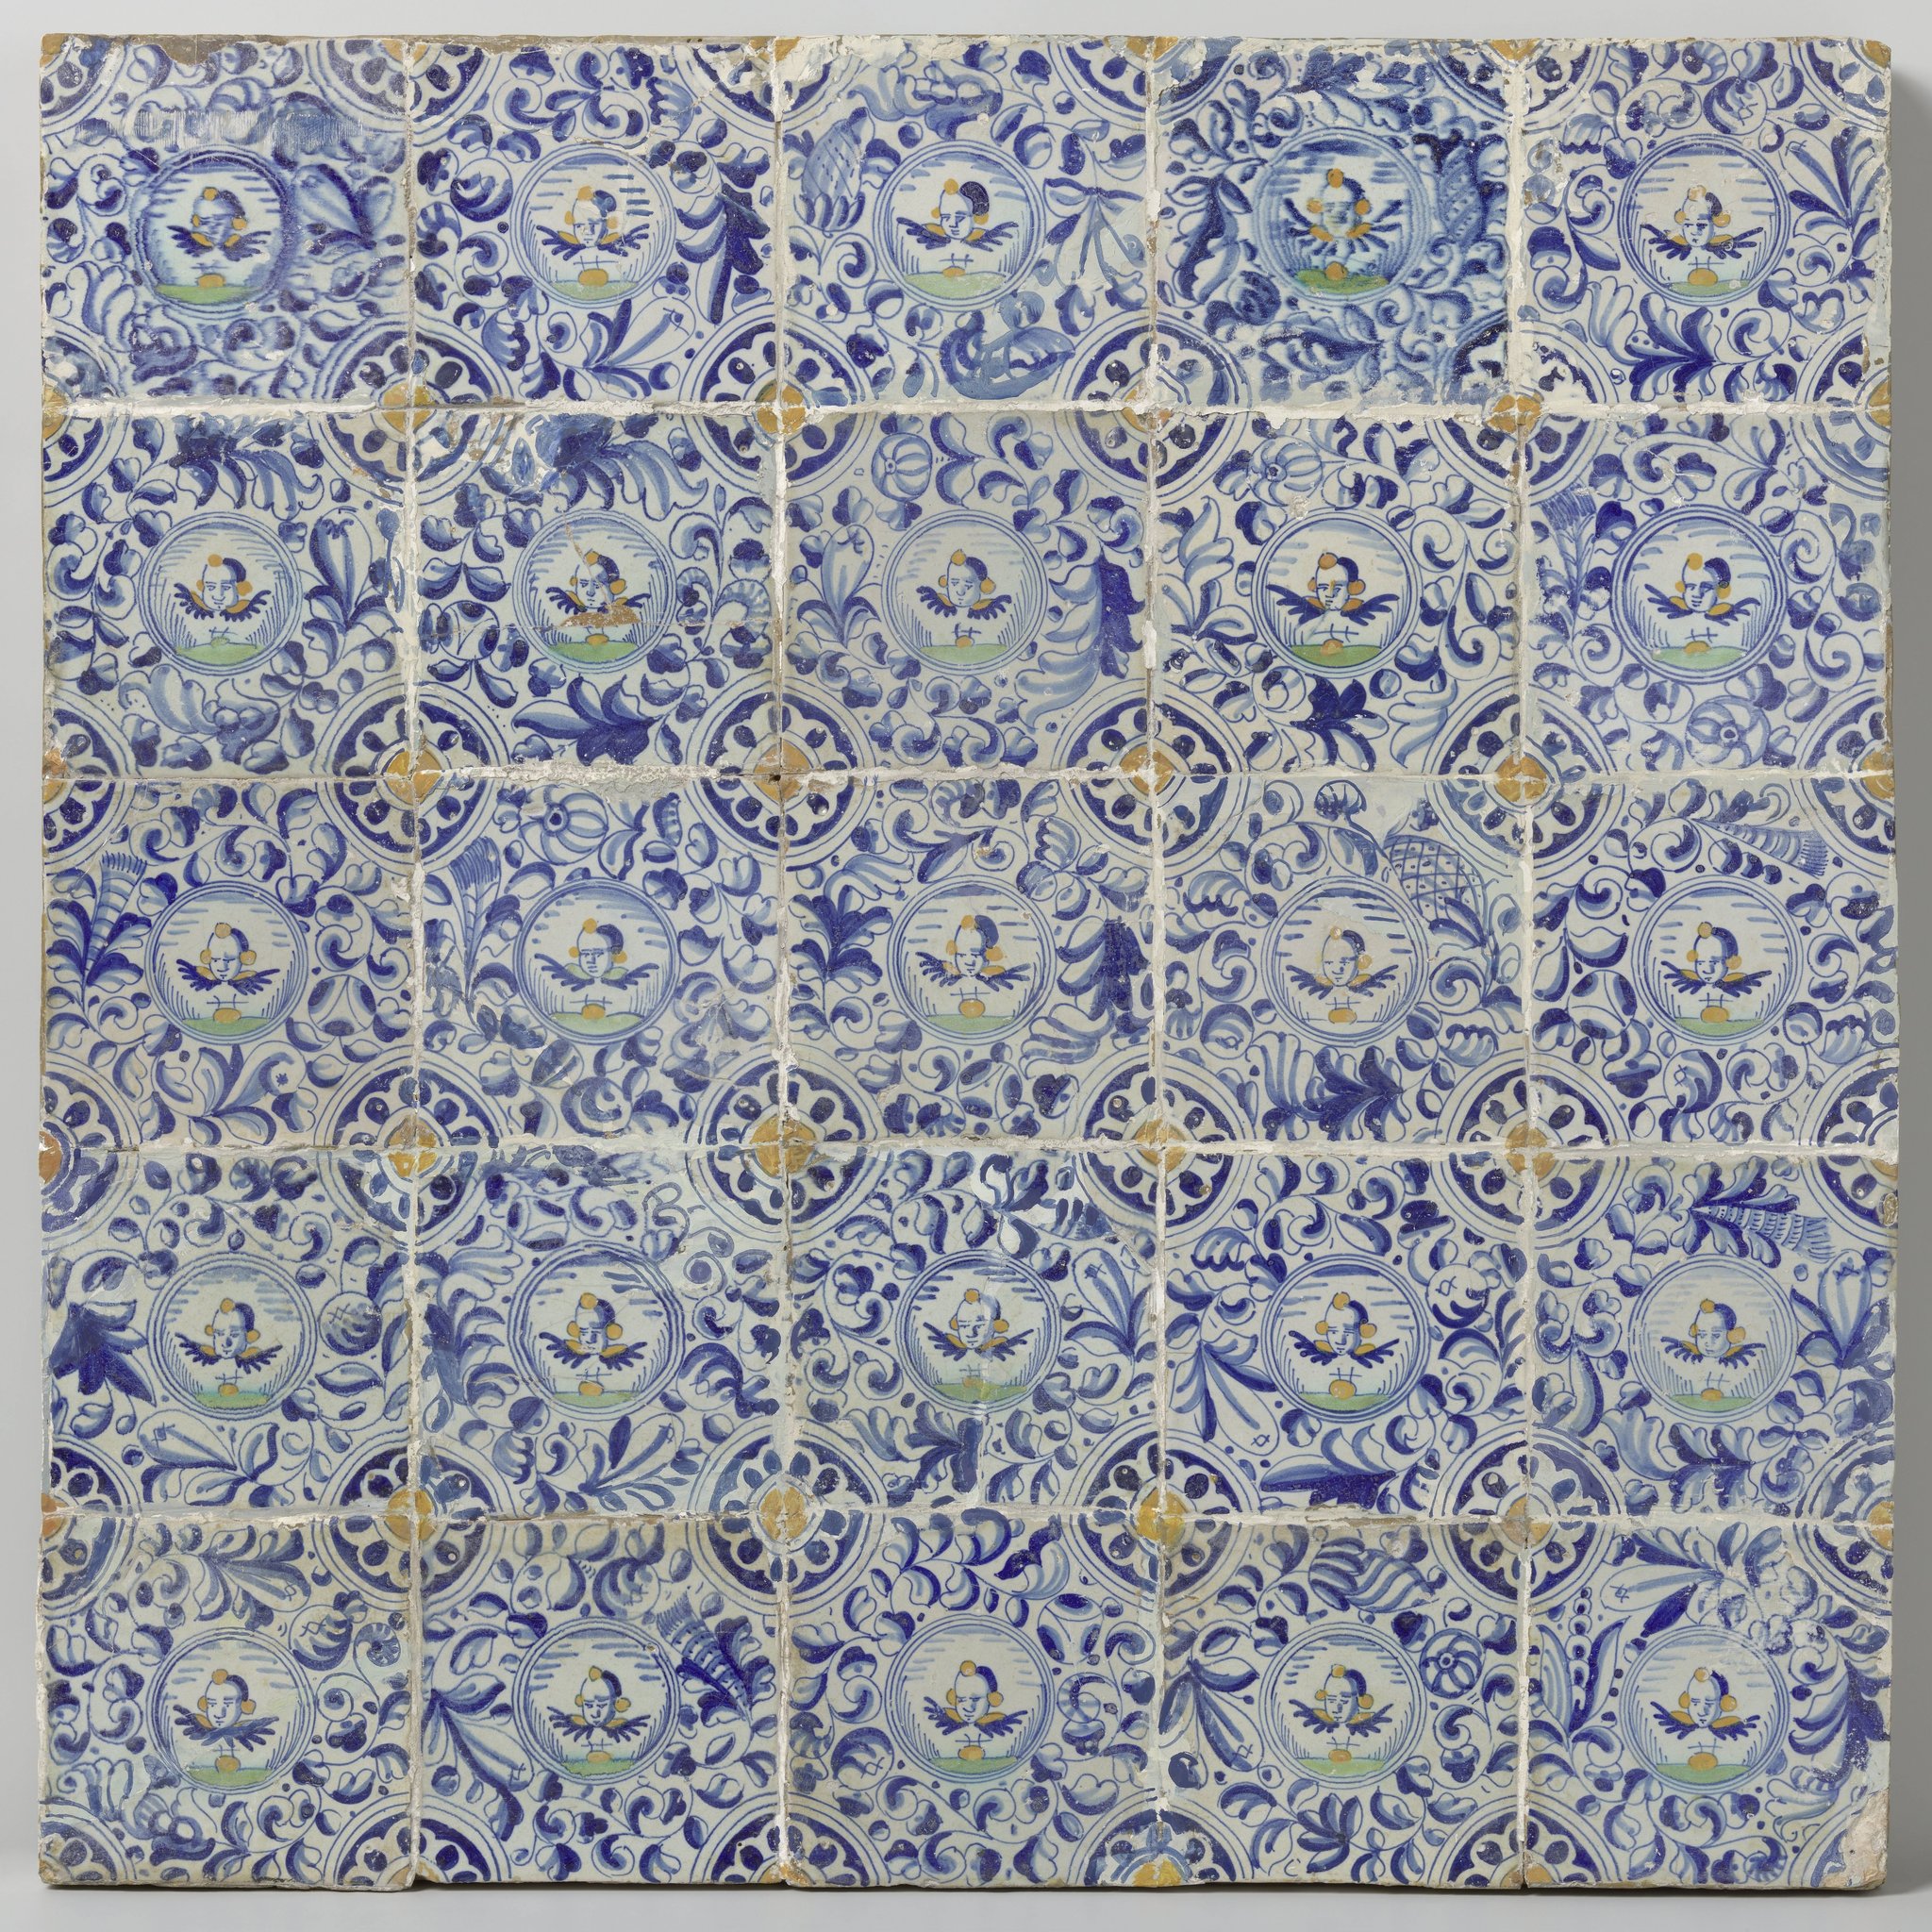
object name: tegelveld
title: Veld van vijfentwintig tegels met engelenhoofden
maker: Anonymous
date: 1615-1625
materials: earthenware, glaze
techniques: maiolica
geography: netherlands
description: Veld van vijfentwintig tegels (5 x 5) elk met een veelkleurig (blauw, oranje en groen) cherubkopje in een cirkel omgeven door eikenblad. In de hoeken, een kwart rozet.